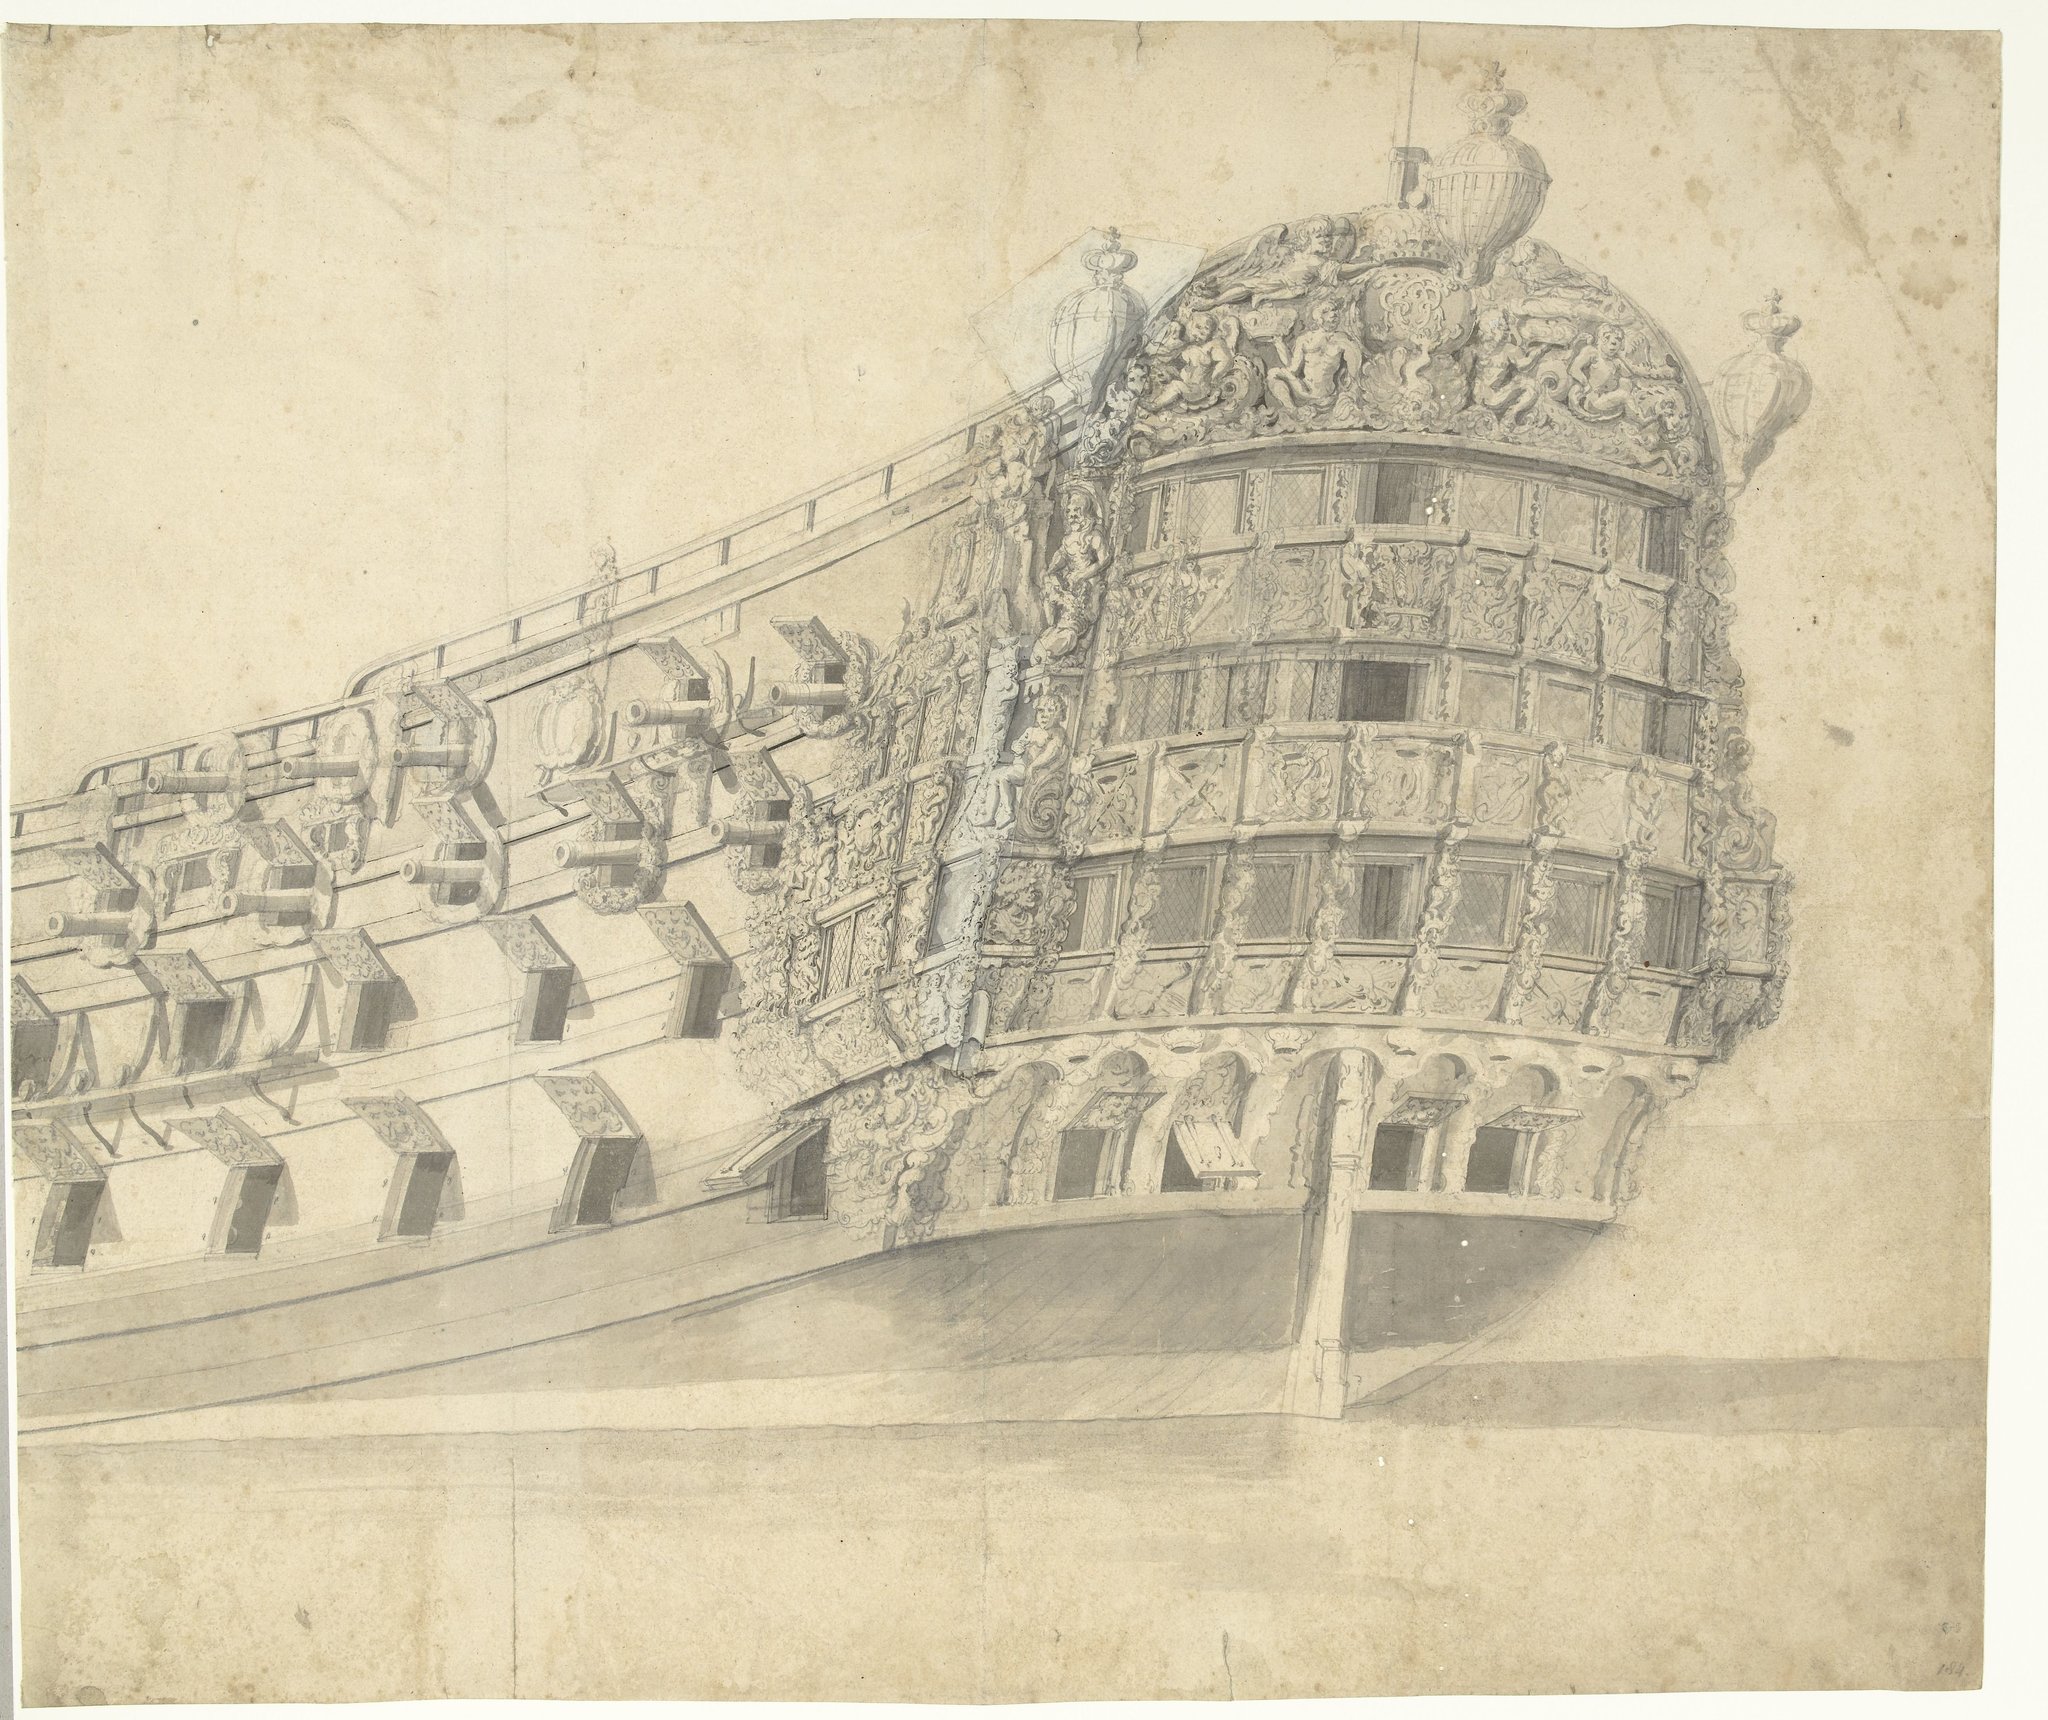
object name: drawing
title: Rijkversierd Engels (?) fregat (rechterblad)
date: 1621-1693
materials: ink, paper, pencil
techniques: brush, pen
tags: sailing-ship, sailing-boat, navy (+ sailing-ships)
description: Zijaanzicht van een rijkversierd Engels (?) fregat. Rechterblad van voorstelling samengesteld uit twee bladen (linkerblad heeft objectnummer RP-T-00-407).